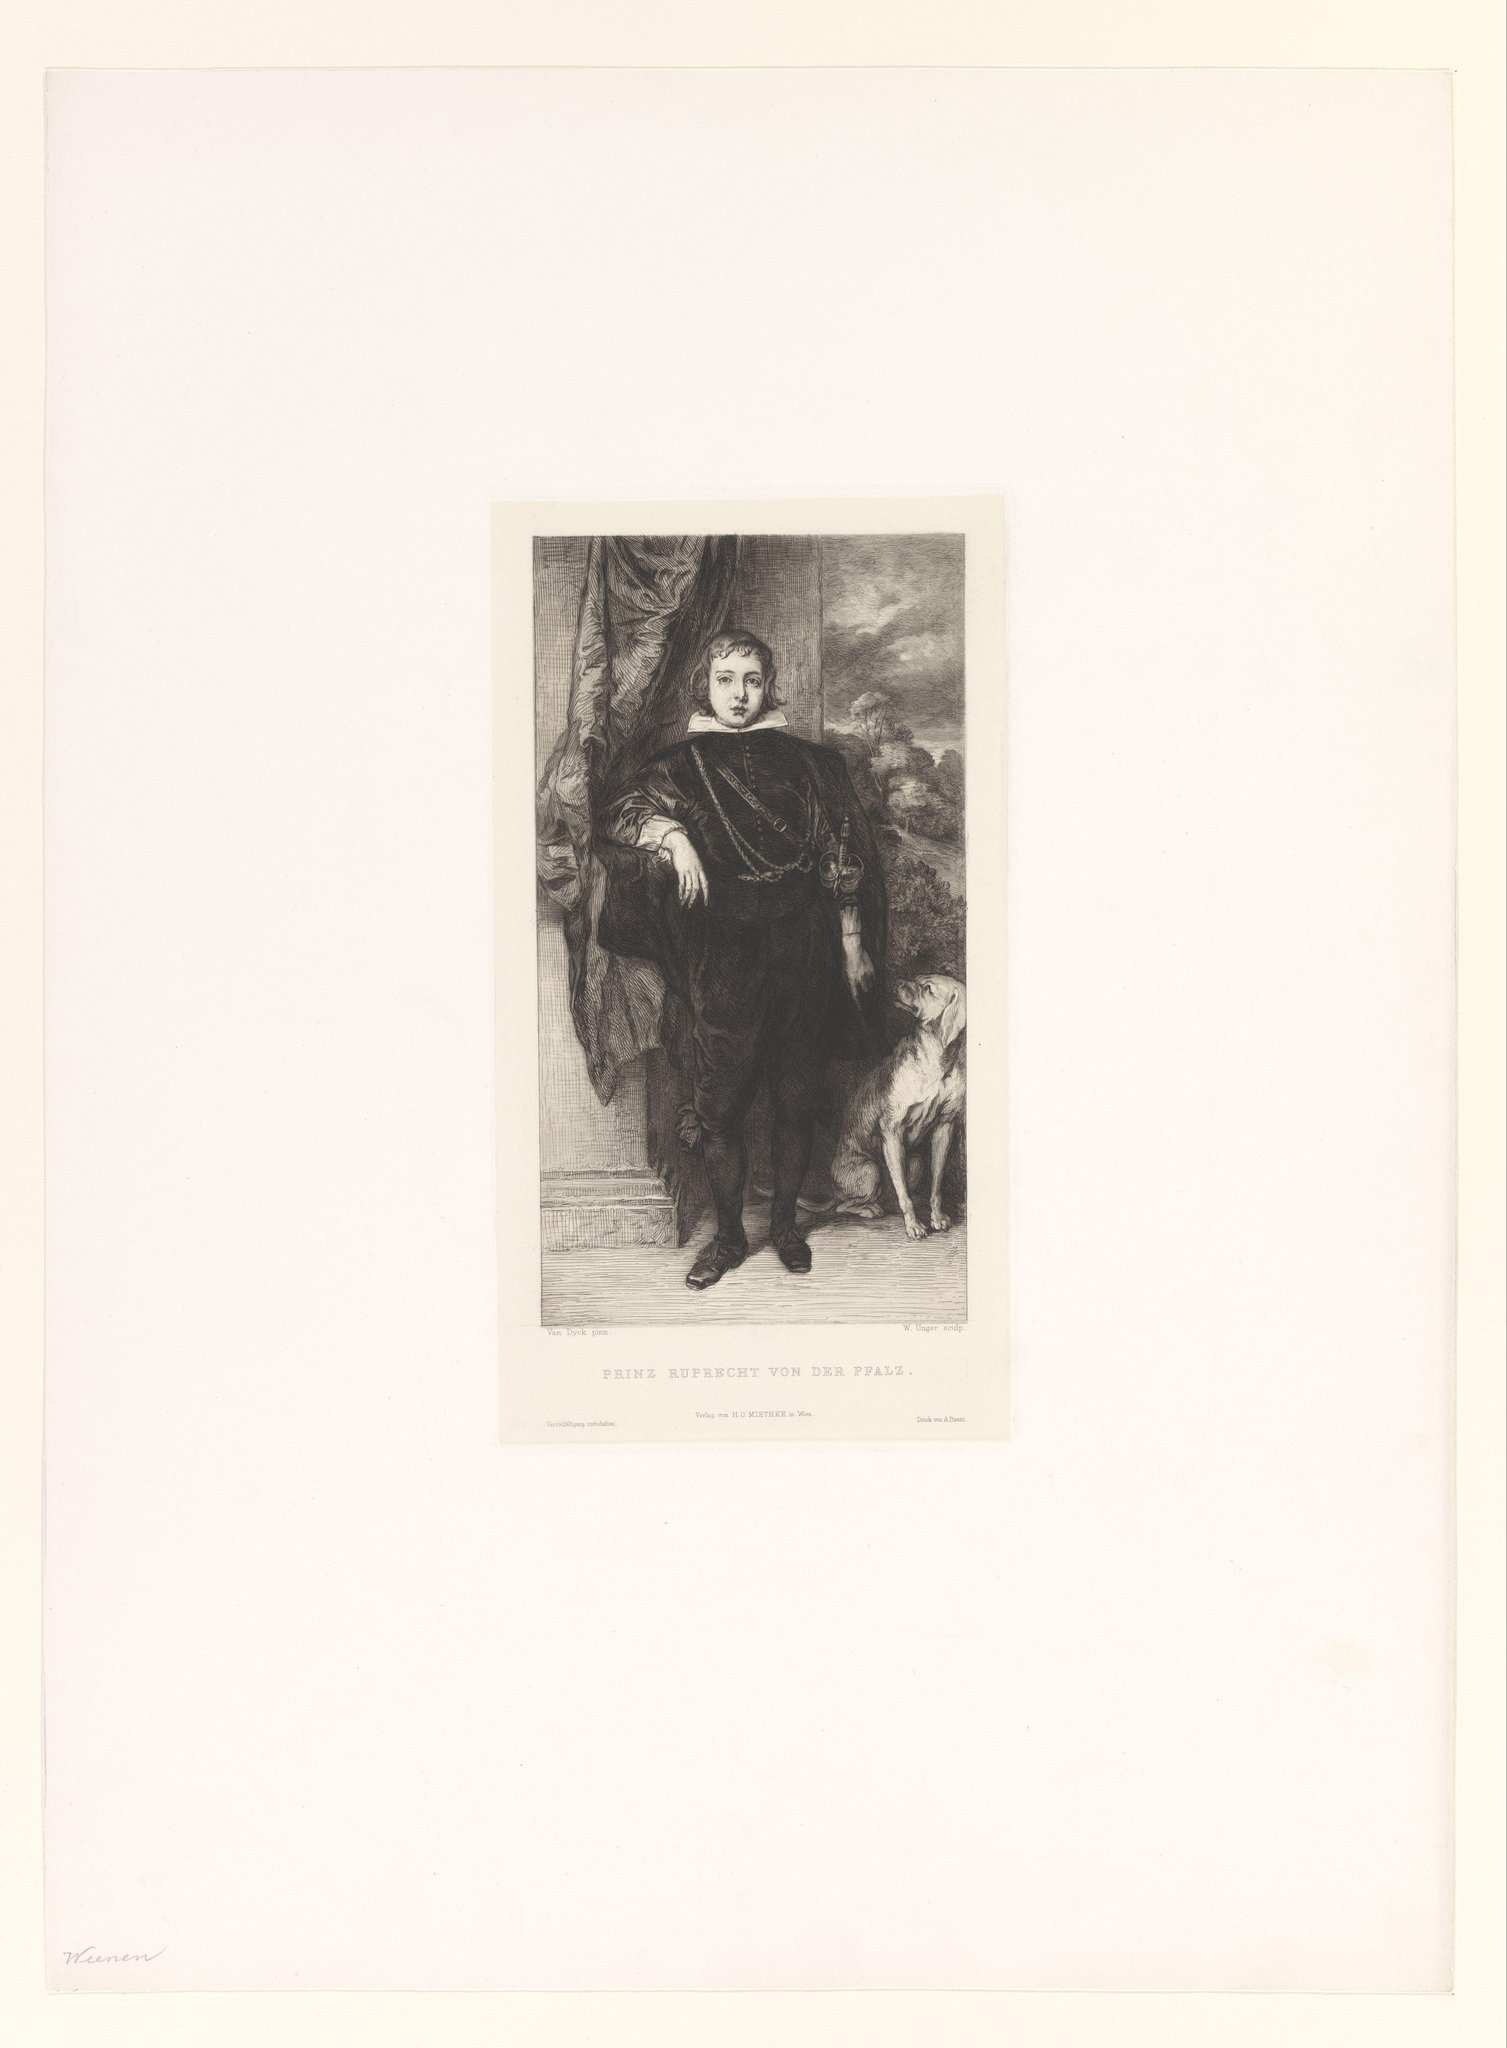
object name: print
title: Prinz Ruprecht von der Pfalz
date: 1861-1889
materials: paper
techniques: etching, intaglio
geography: vienna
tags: prague, london, painter, print maker, draughtsman, prinz ruprecht, historical persons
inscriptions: collector's mark: Lugt 2228